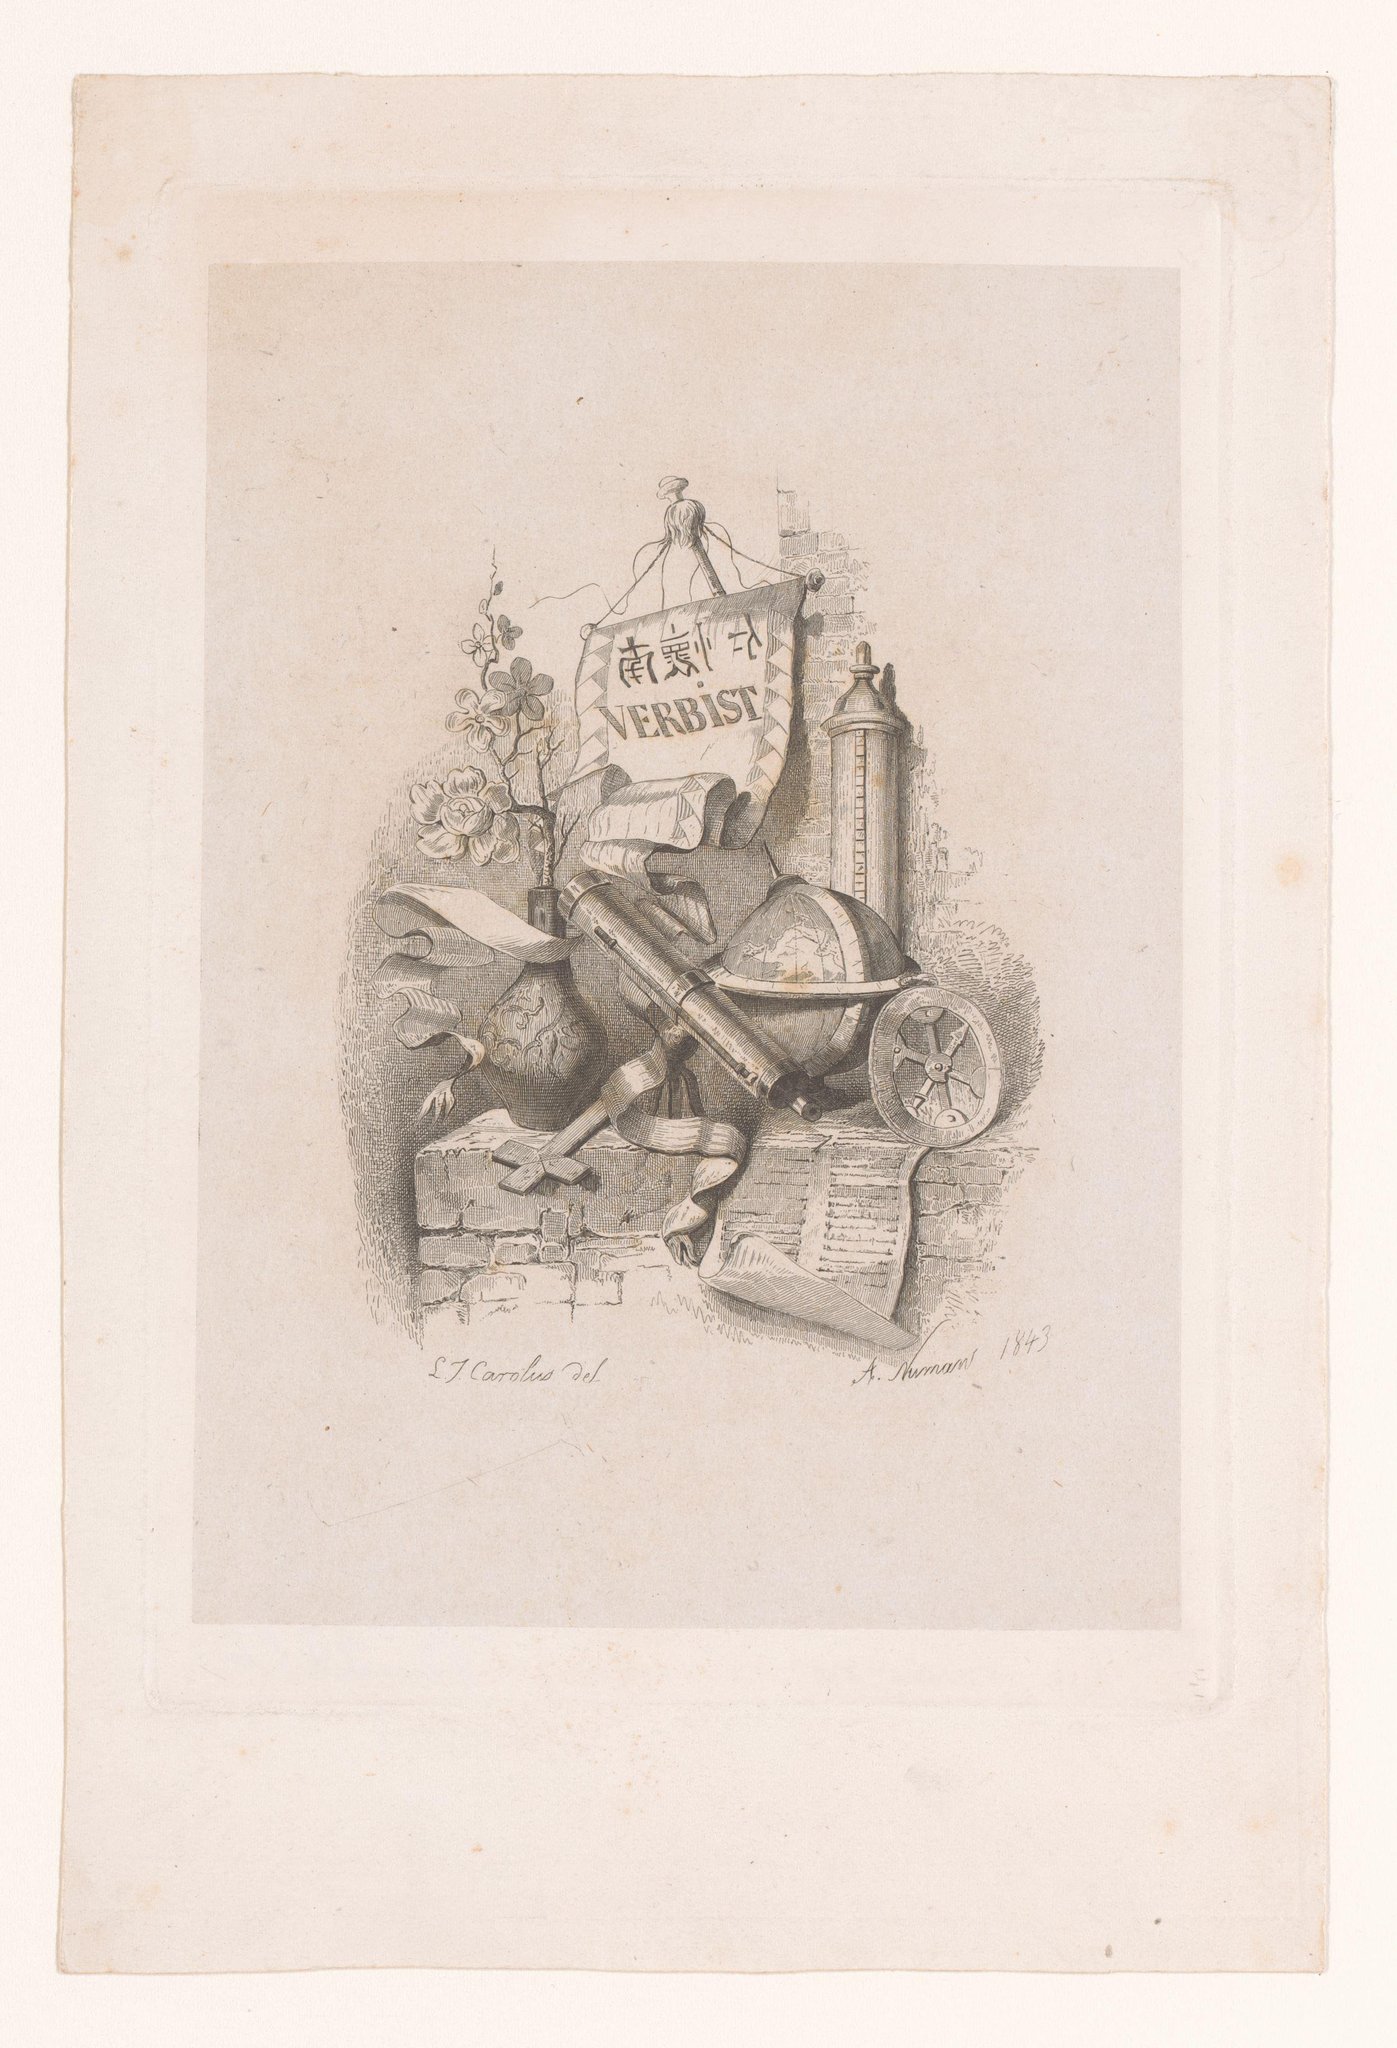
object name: print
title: Stilleven met astronomische objecten, een vaas met bloemen, een kruis en een vaandel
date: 1843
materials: paper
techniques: etching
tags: banner, standard (as symbol of the state, etc.), telescope, flowers in a vase, globe, still life of miscellaneous objects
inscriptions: collector's mark: Lugt 2228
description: Mogelijk gaat het om een stilleven verwijzend naar Theofiel Verbist, een priester die ook in China werkzaam is geweest.